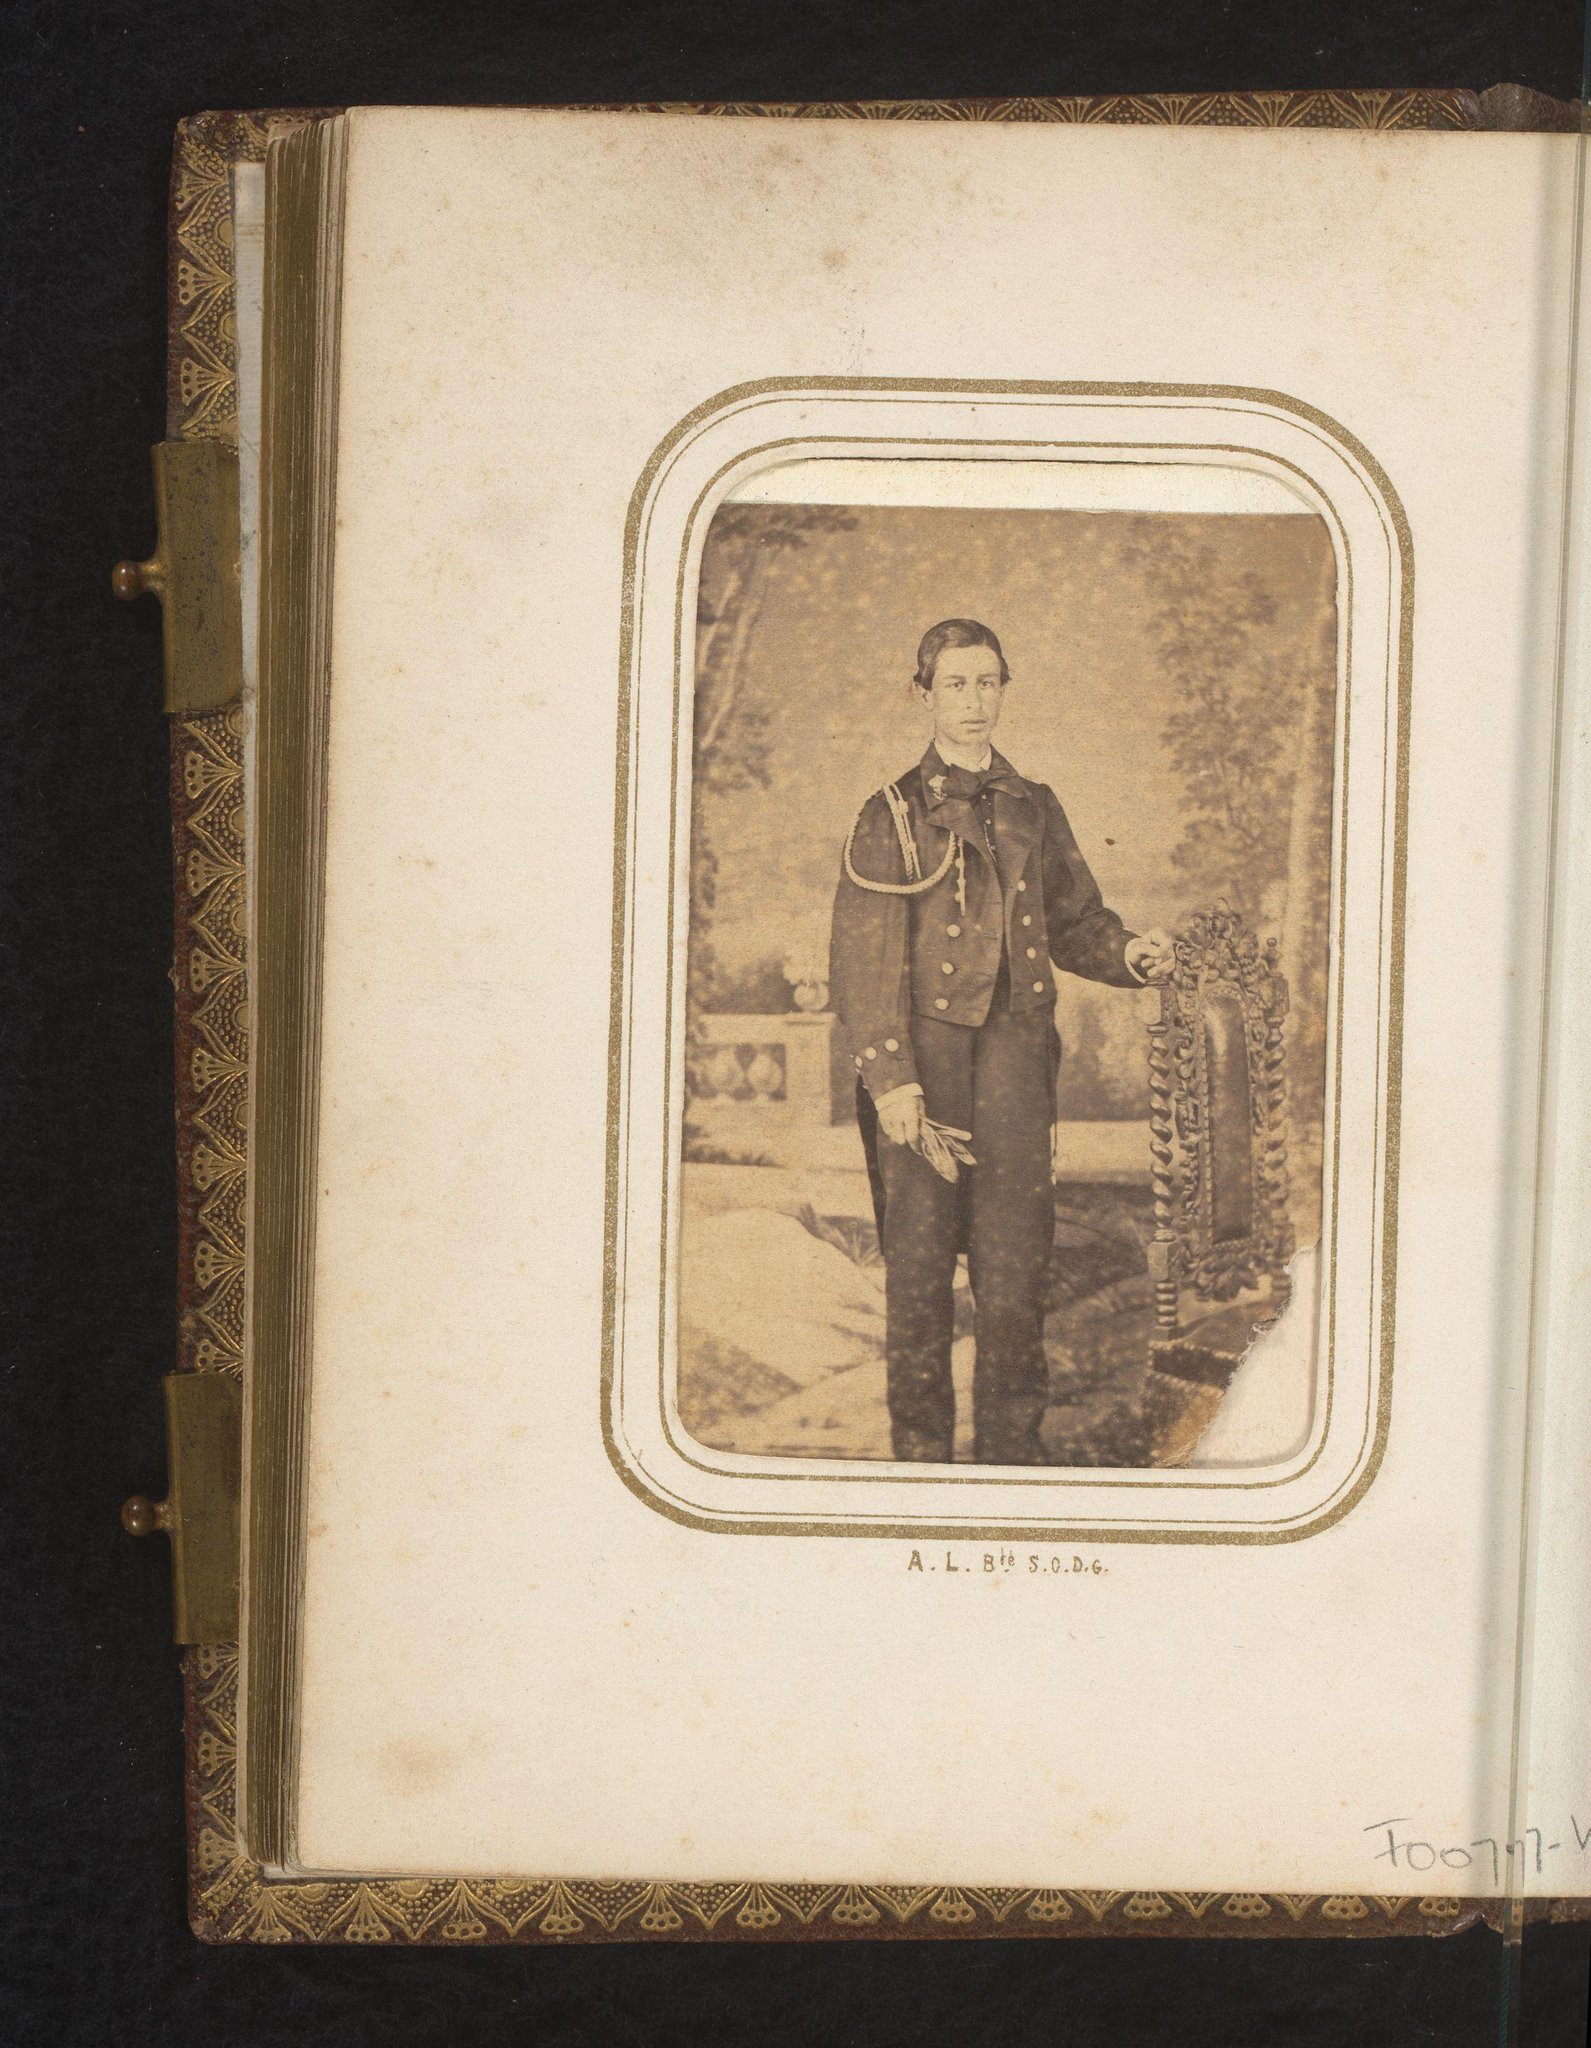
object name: photograph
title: Portret van een staande jongeman in uniform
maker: josé maria blanco aguilar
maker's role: fotograaf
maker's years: 1823-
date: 1867-1868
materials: cardboard, photographic support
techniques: albumen print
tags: historical persons, youth, adolescent, (military) uniforms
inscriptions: inscription: ‘Jose Ma Blanco/ Fotografo/ Calle estuario 20, Cádiz’, inscription: ‘A.L. B.te S.C.D.G.’